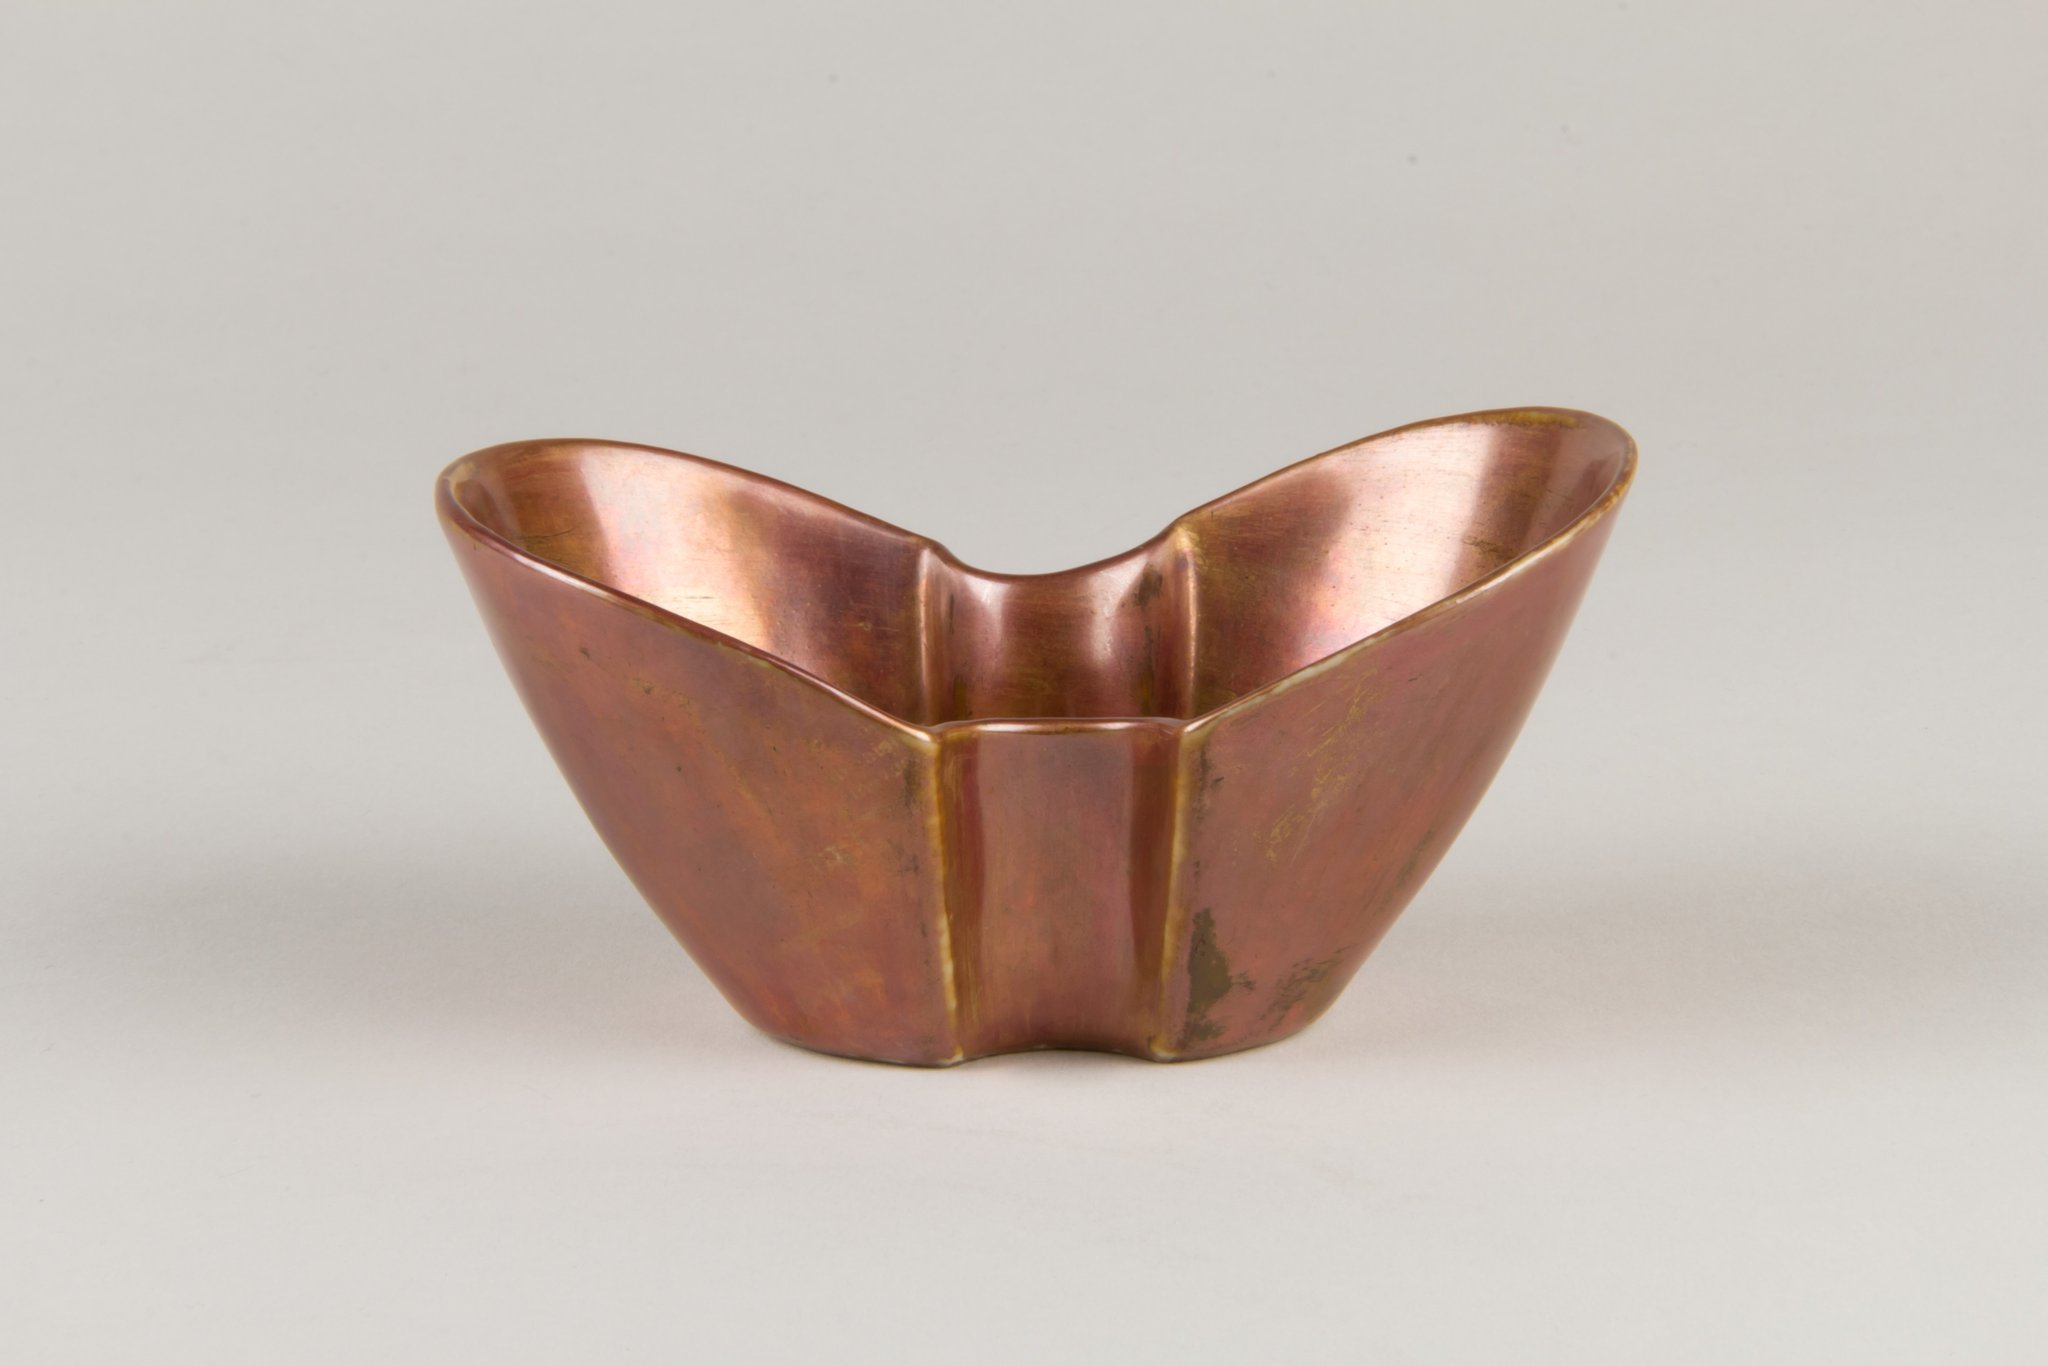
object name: cup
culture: chinese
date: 1801-1850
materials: gilt, porcelain